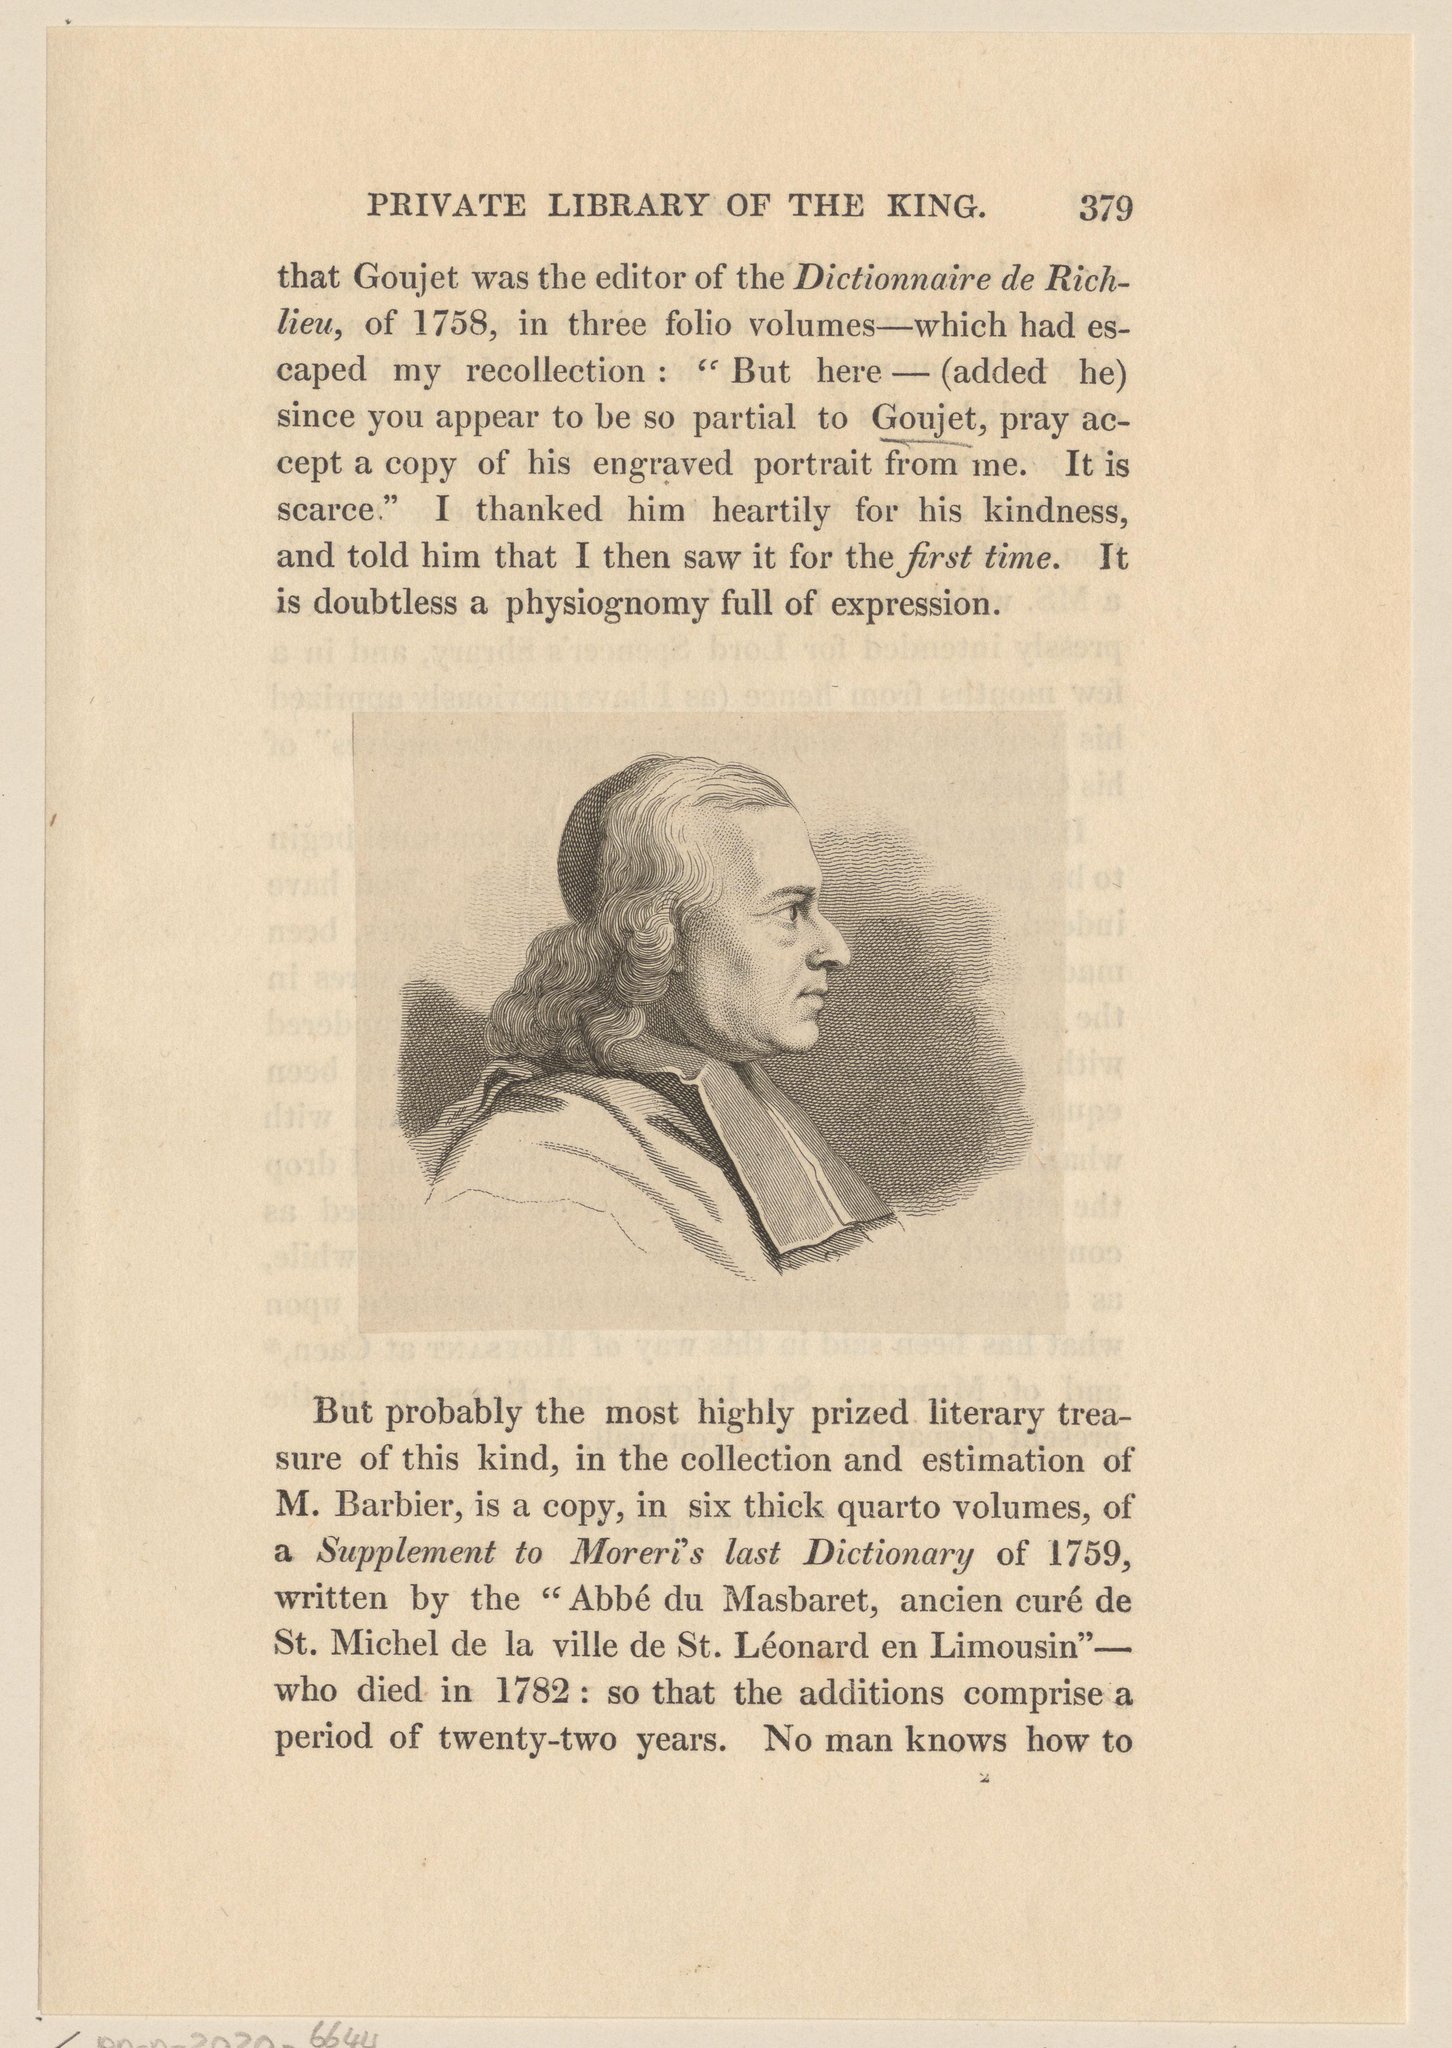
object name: print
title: Portret van Claude Pierre Goujet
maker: Anonymous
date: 1821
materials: paper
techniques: engraving, etching, letterpress printing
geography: london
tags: historical persons, nobility and patriciate; chivalry, knighthood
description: Prent uit: Dibdin, Thomas Frognall. A Bibliographical Antiquarian and Picturesque Tour. Londen: Payne and Foss, et al., 1821, dl. 2, p. 379.